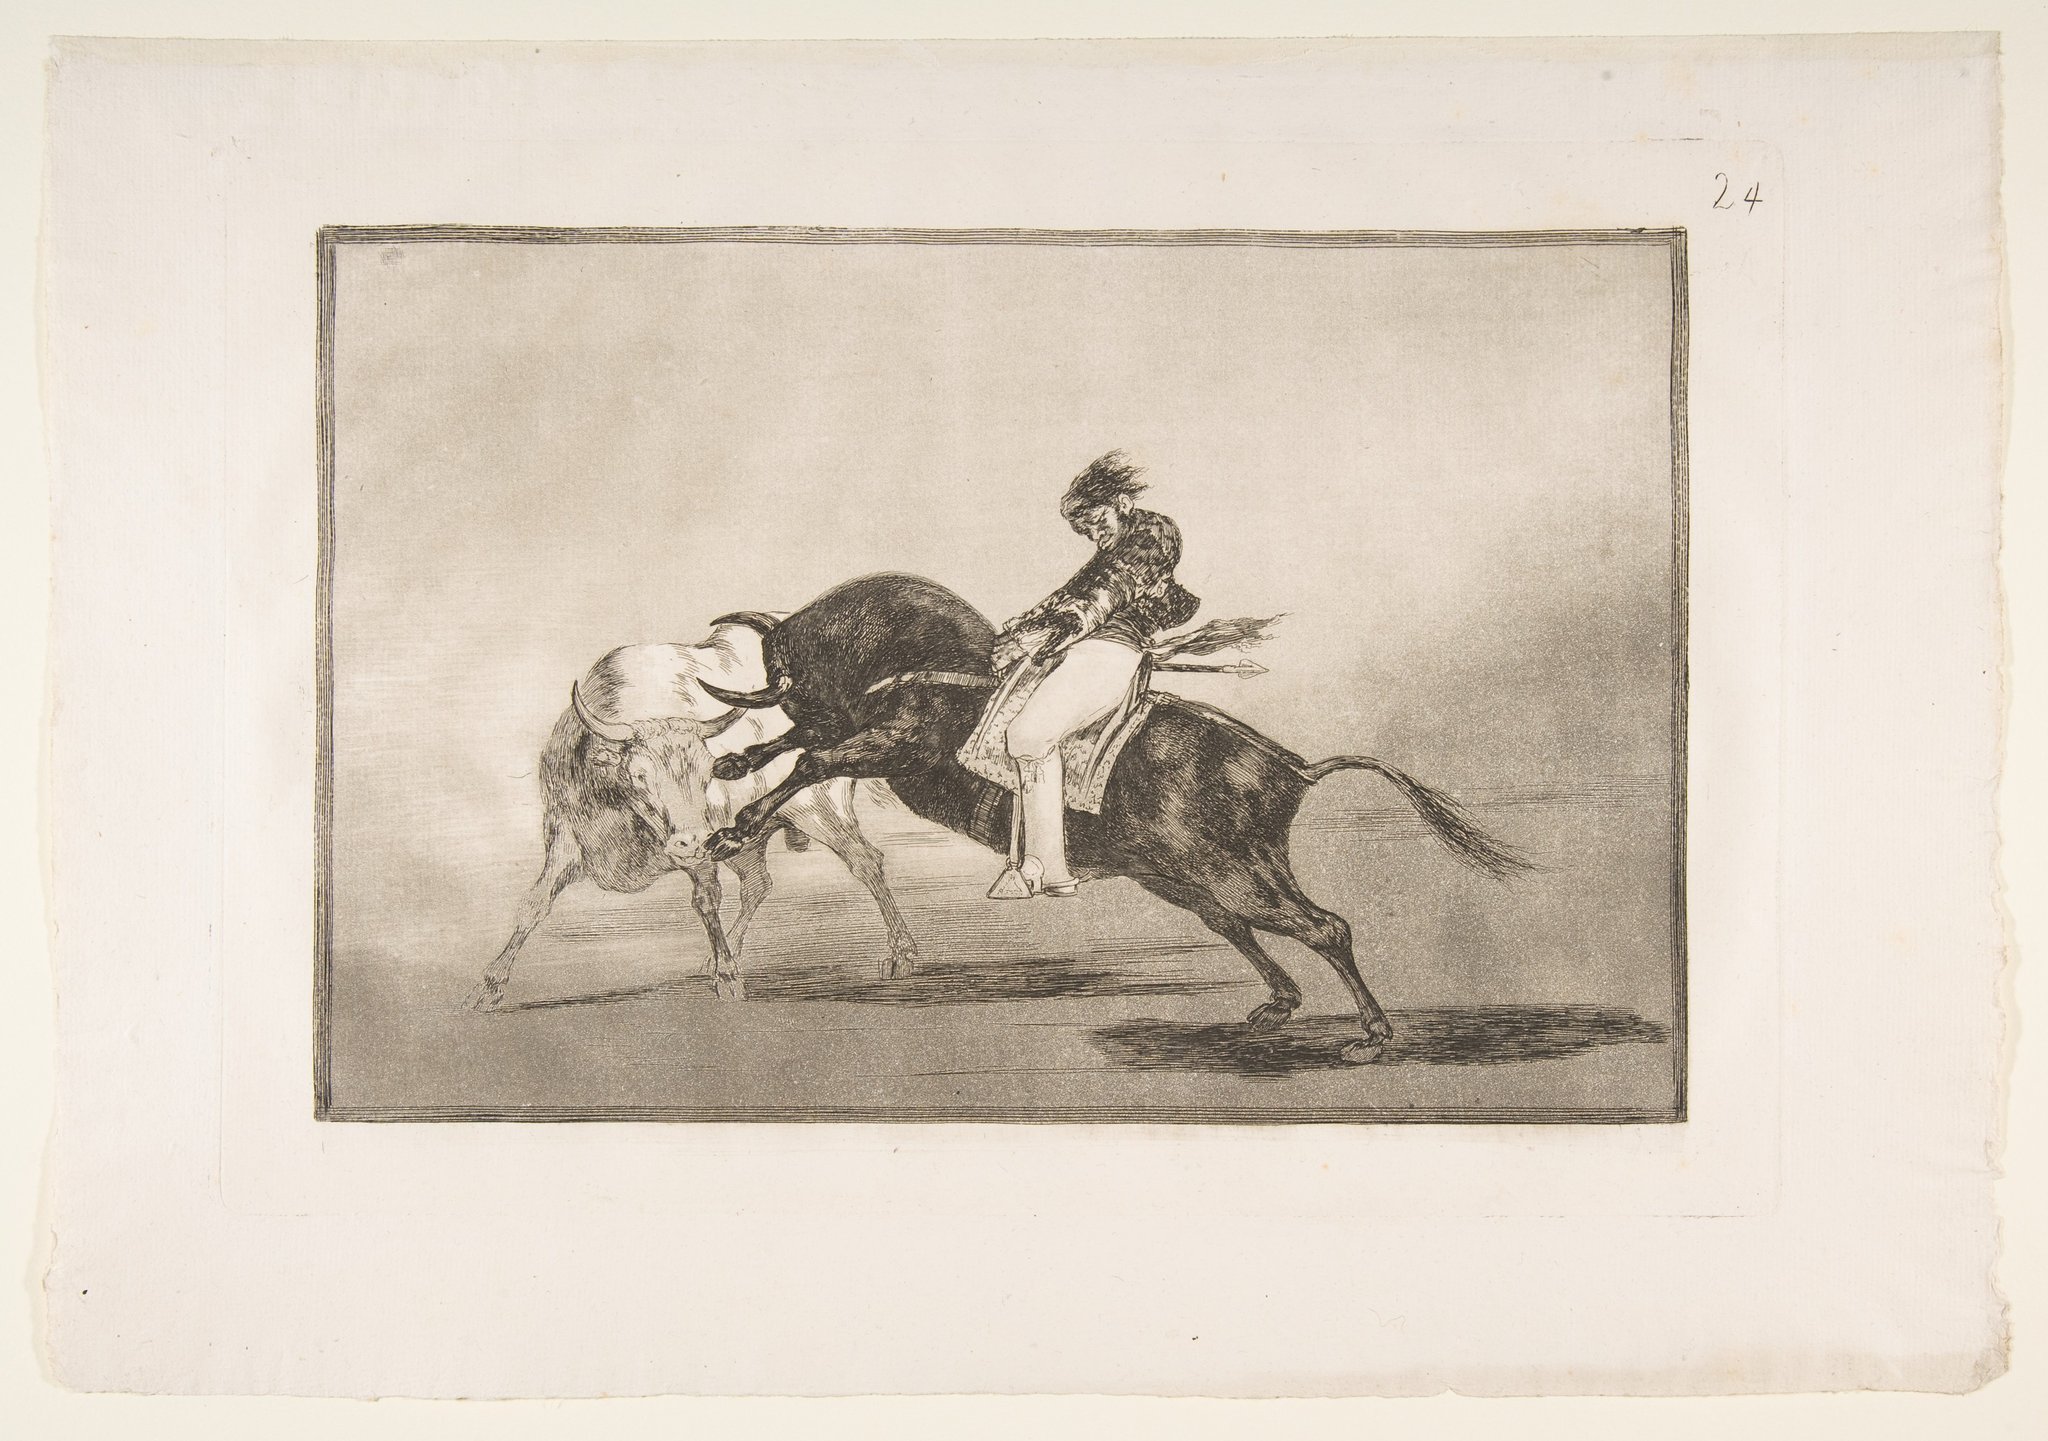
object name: print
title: Plate 24 of "La Tauromaquia": The same Ceballos mounted on another bull breaks short spears in the ring at Madrid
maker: goya (francisco de goya y lucientes)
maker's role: artist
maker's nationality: spanish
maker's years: 1746-1828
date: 1816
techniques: aquatint, engraving, burnishing, drypoint, etching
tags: men,bulls